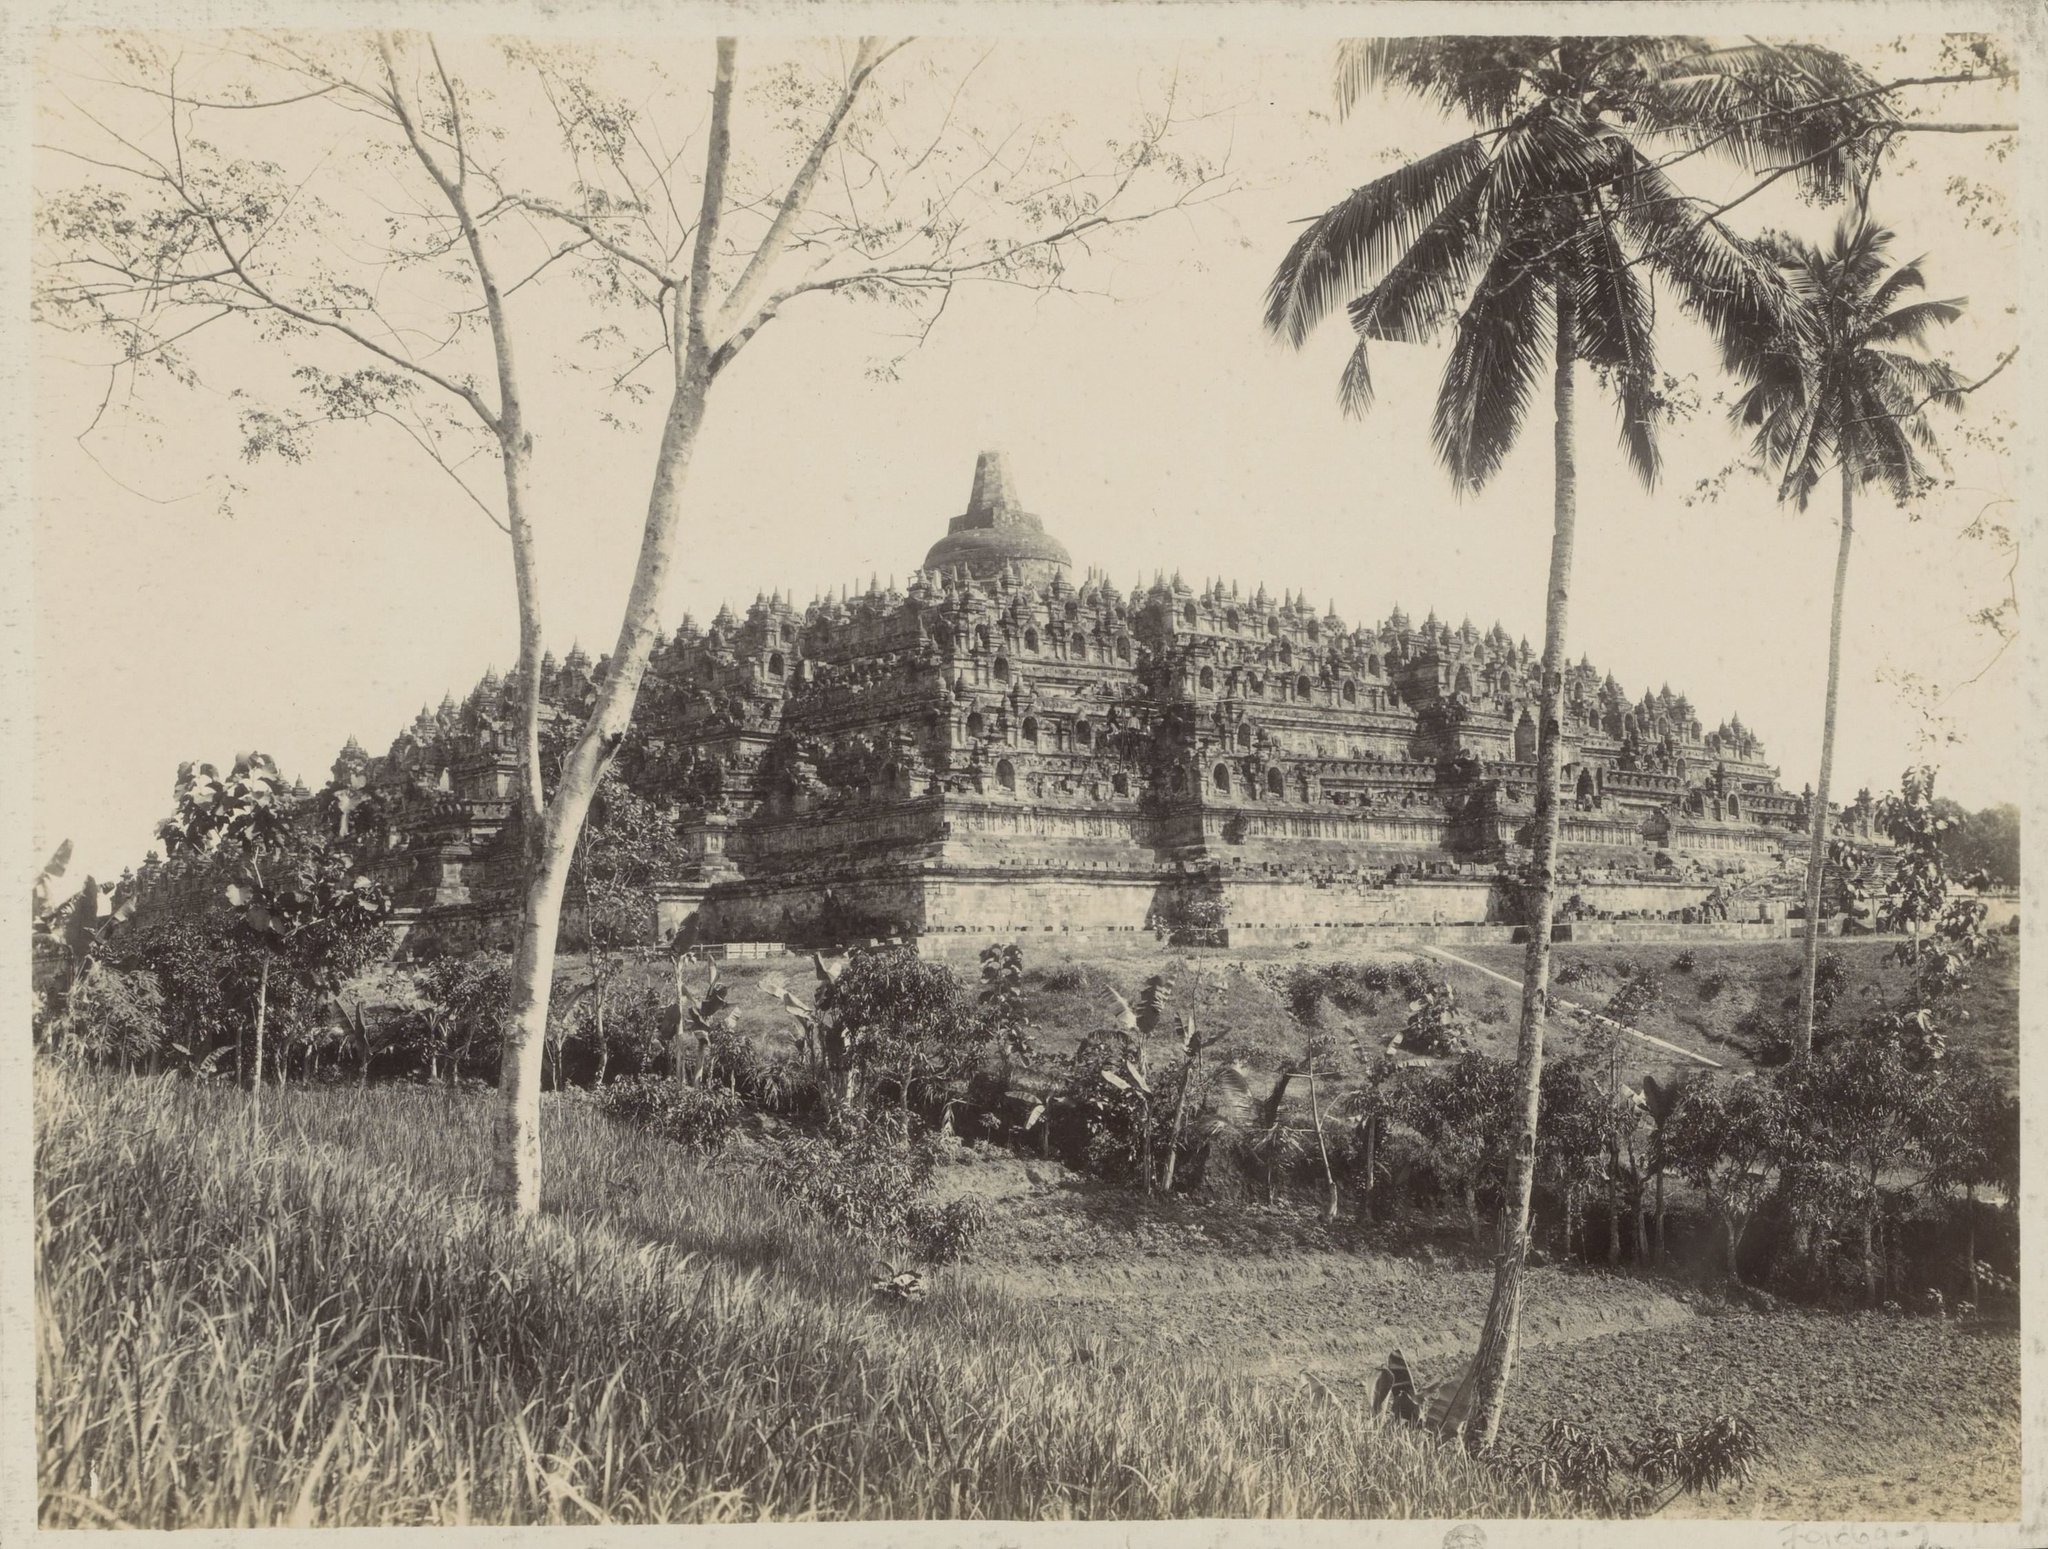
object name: photograph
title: Gezicht op de Borobudur op Java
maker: onnes kurkdjian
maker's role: fotograaf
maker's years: 1851-1903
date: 1912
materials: paper, photographic support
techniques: gelatin silver print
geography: borobudur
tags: temple, shrine ~ hinduism, buddhism, jainism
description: Onderdeel van Reisalbum met veertig foto's van Nederlands-Indië.